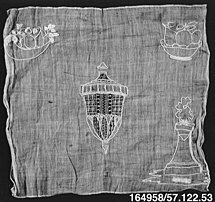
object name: sampler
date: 1801-1900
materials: cotton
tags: fruit